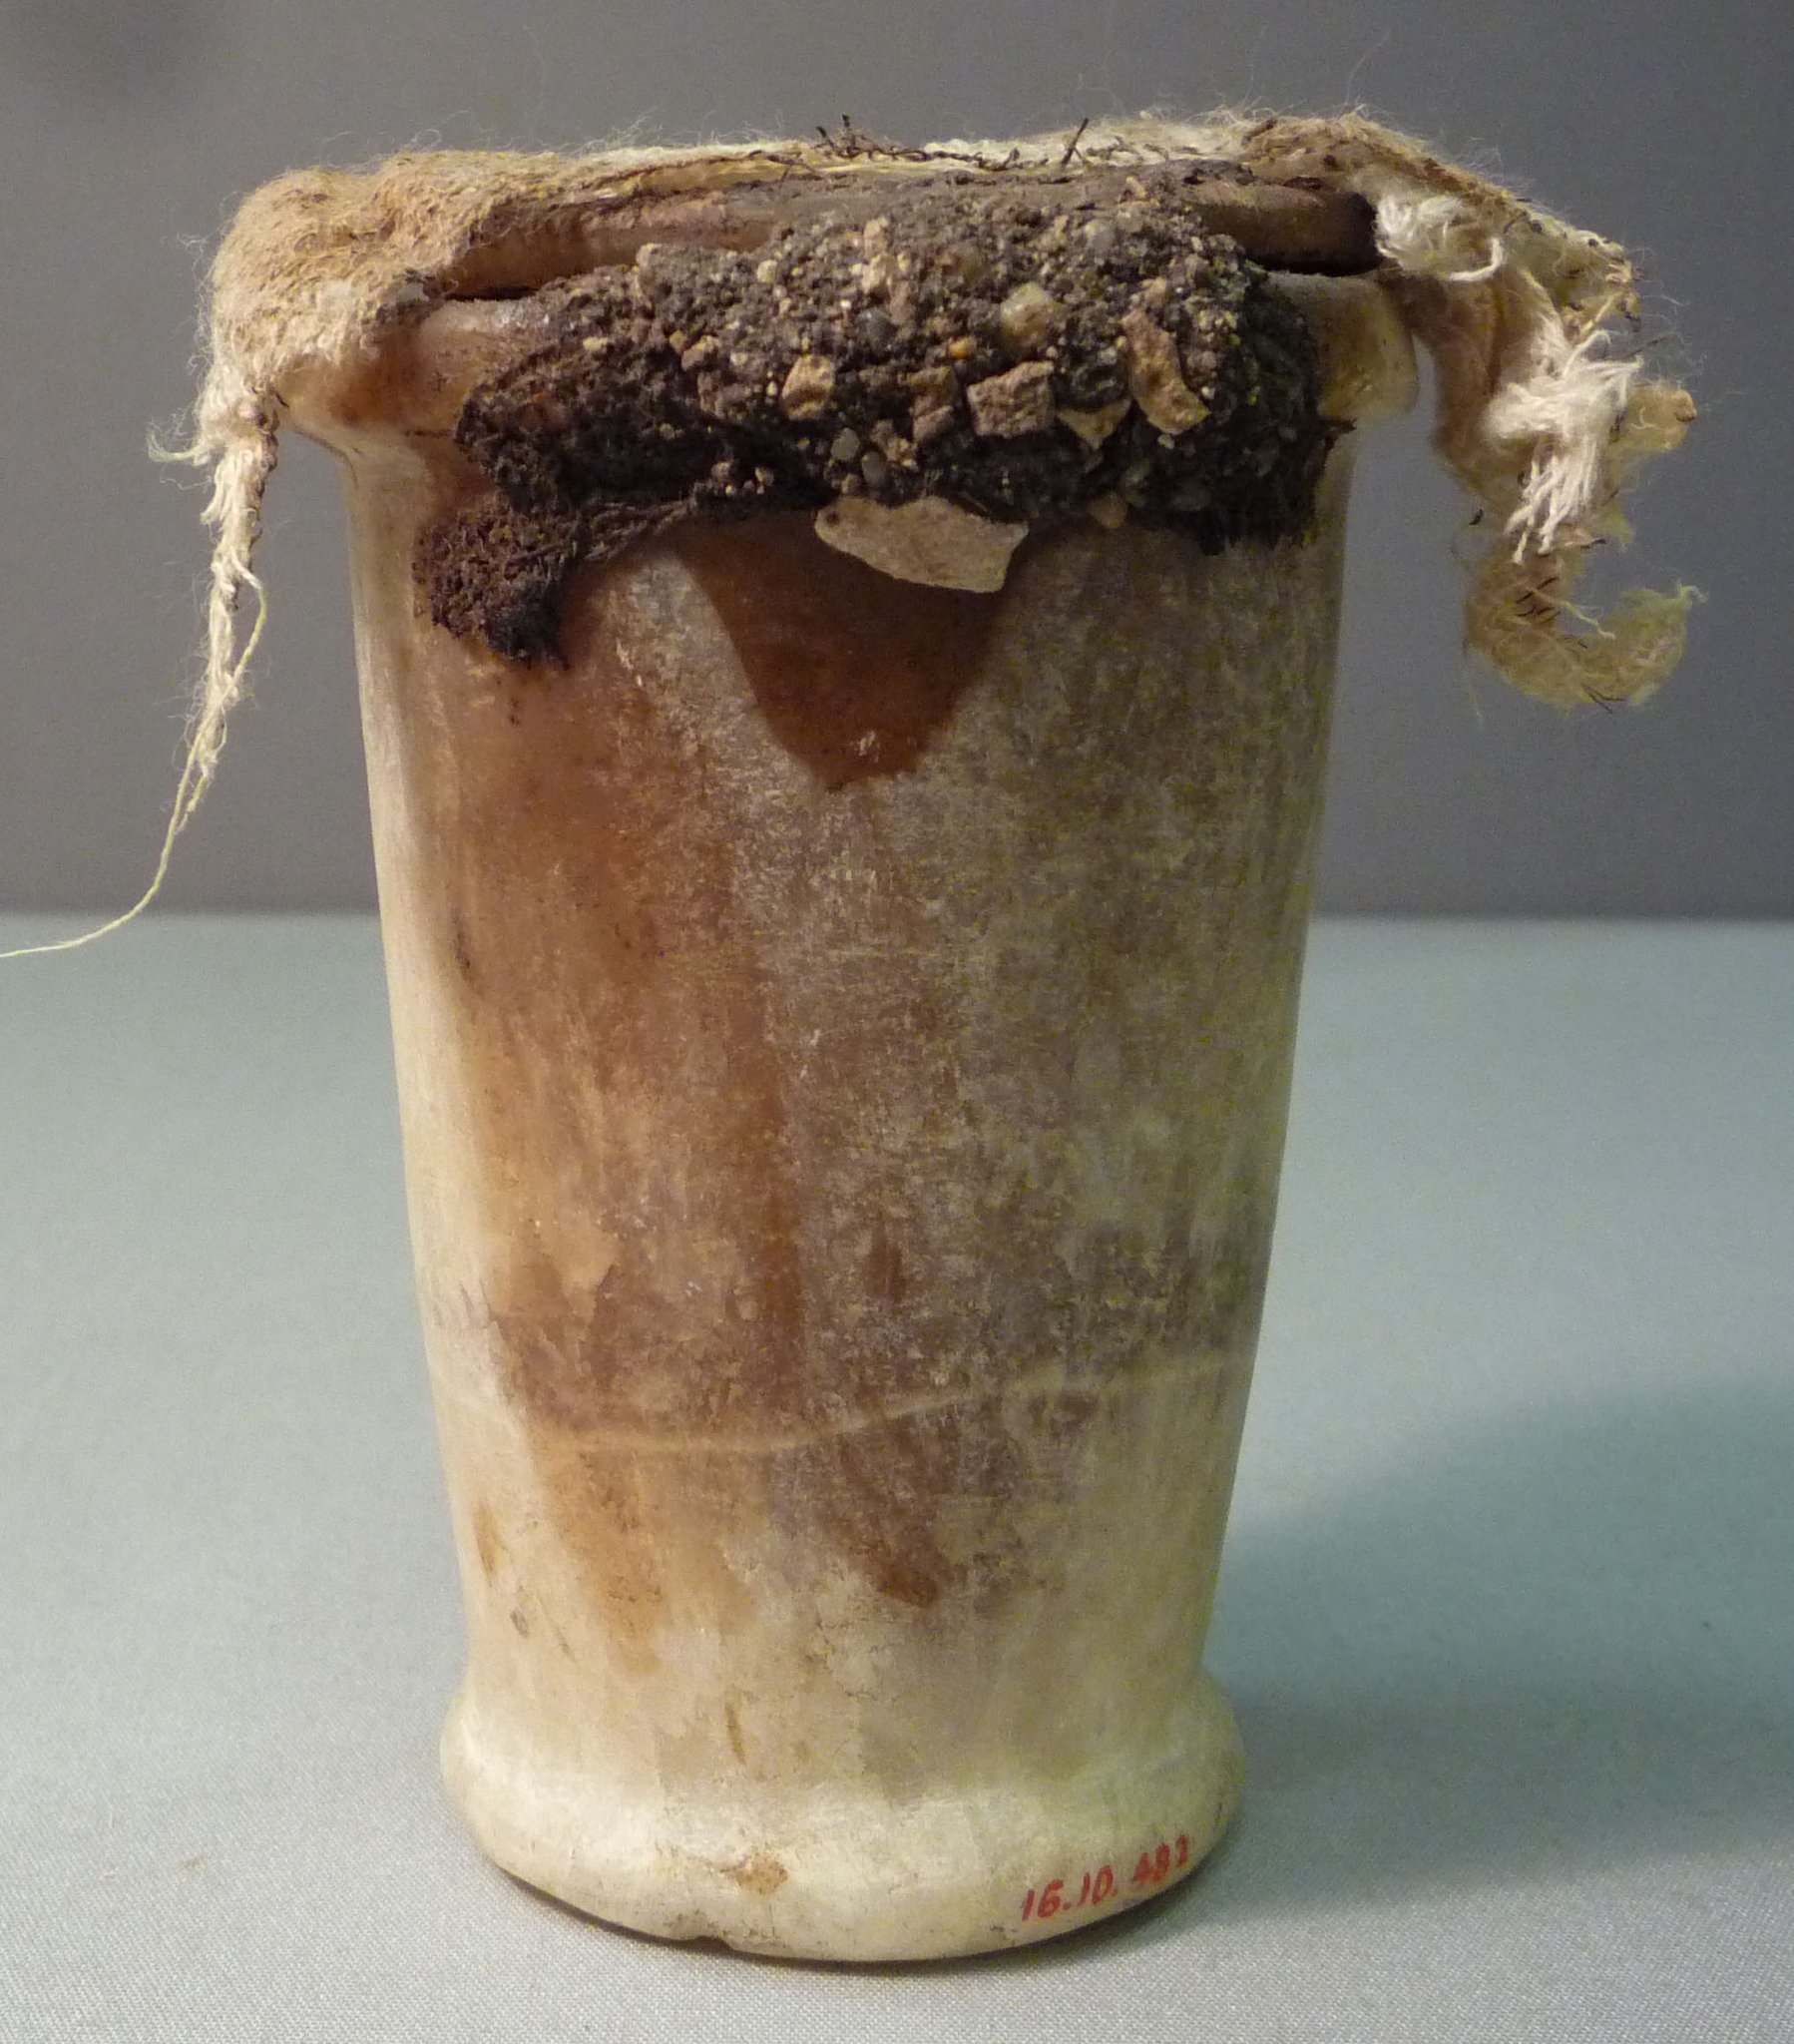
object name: ointment jar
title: Inscribed Ointment Jar From Foundation Deposit 2 of Hatshepsut's Valley Temple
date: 1479-1458 BCE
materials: linen, stone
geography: egypt